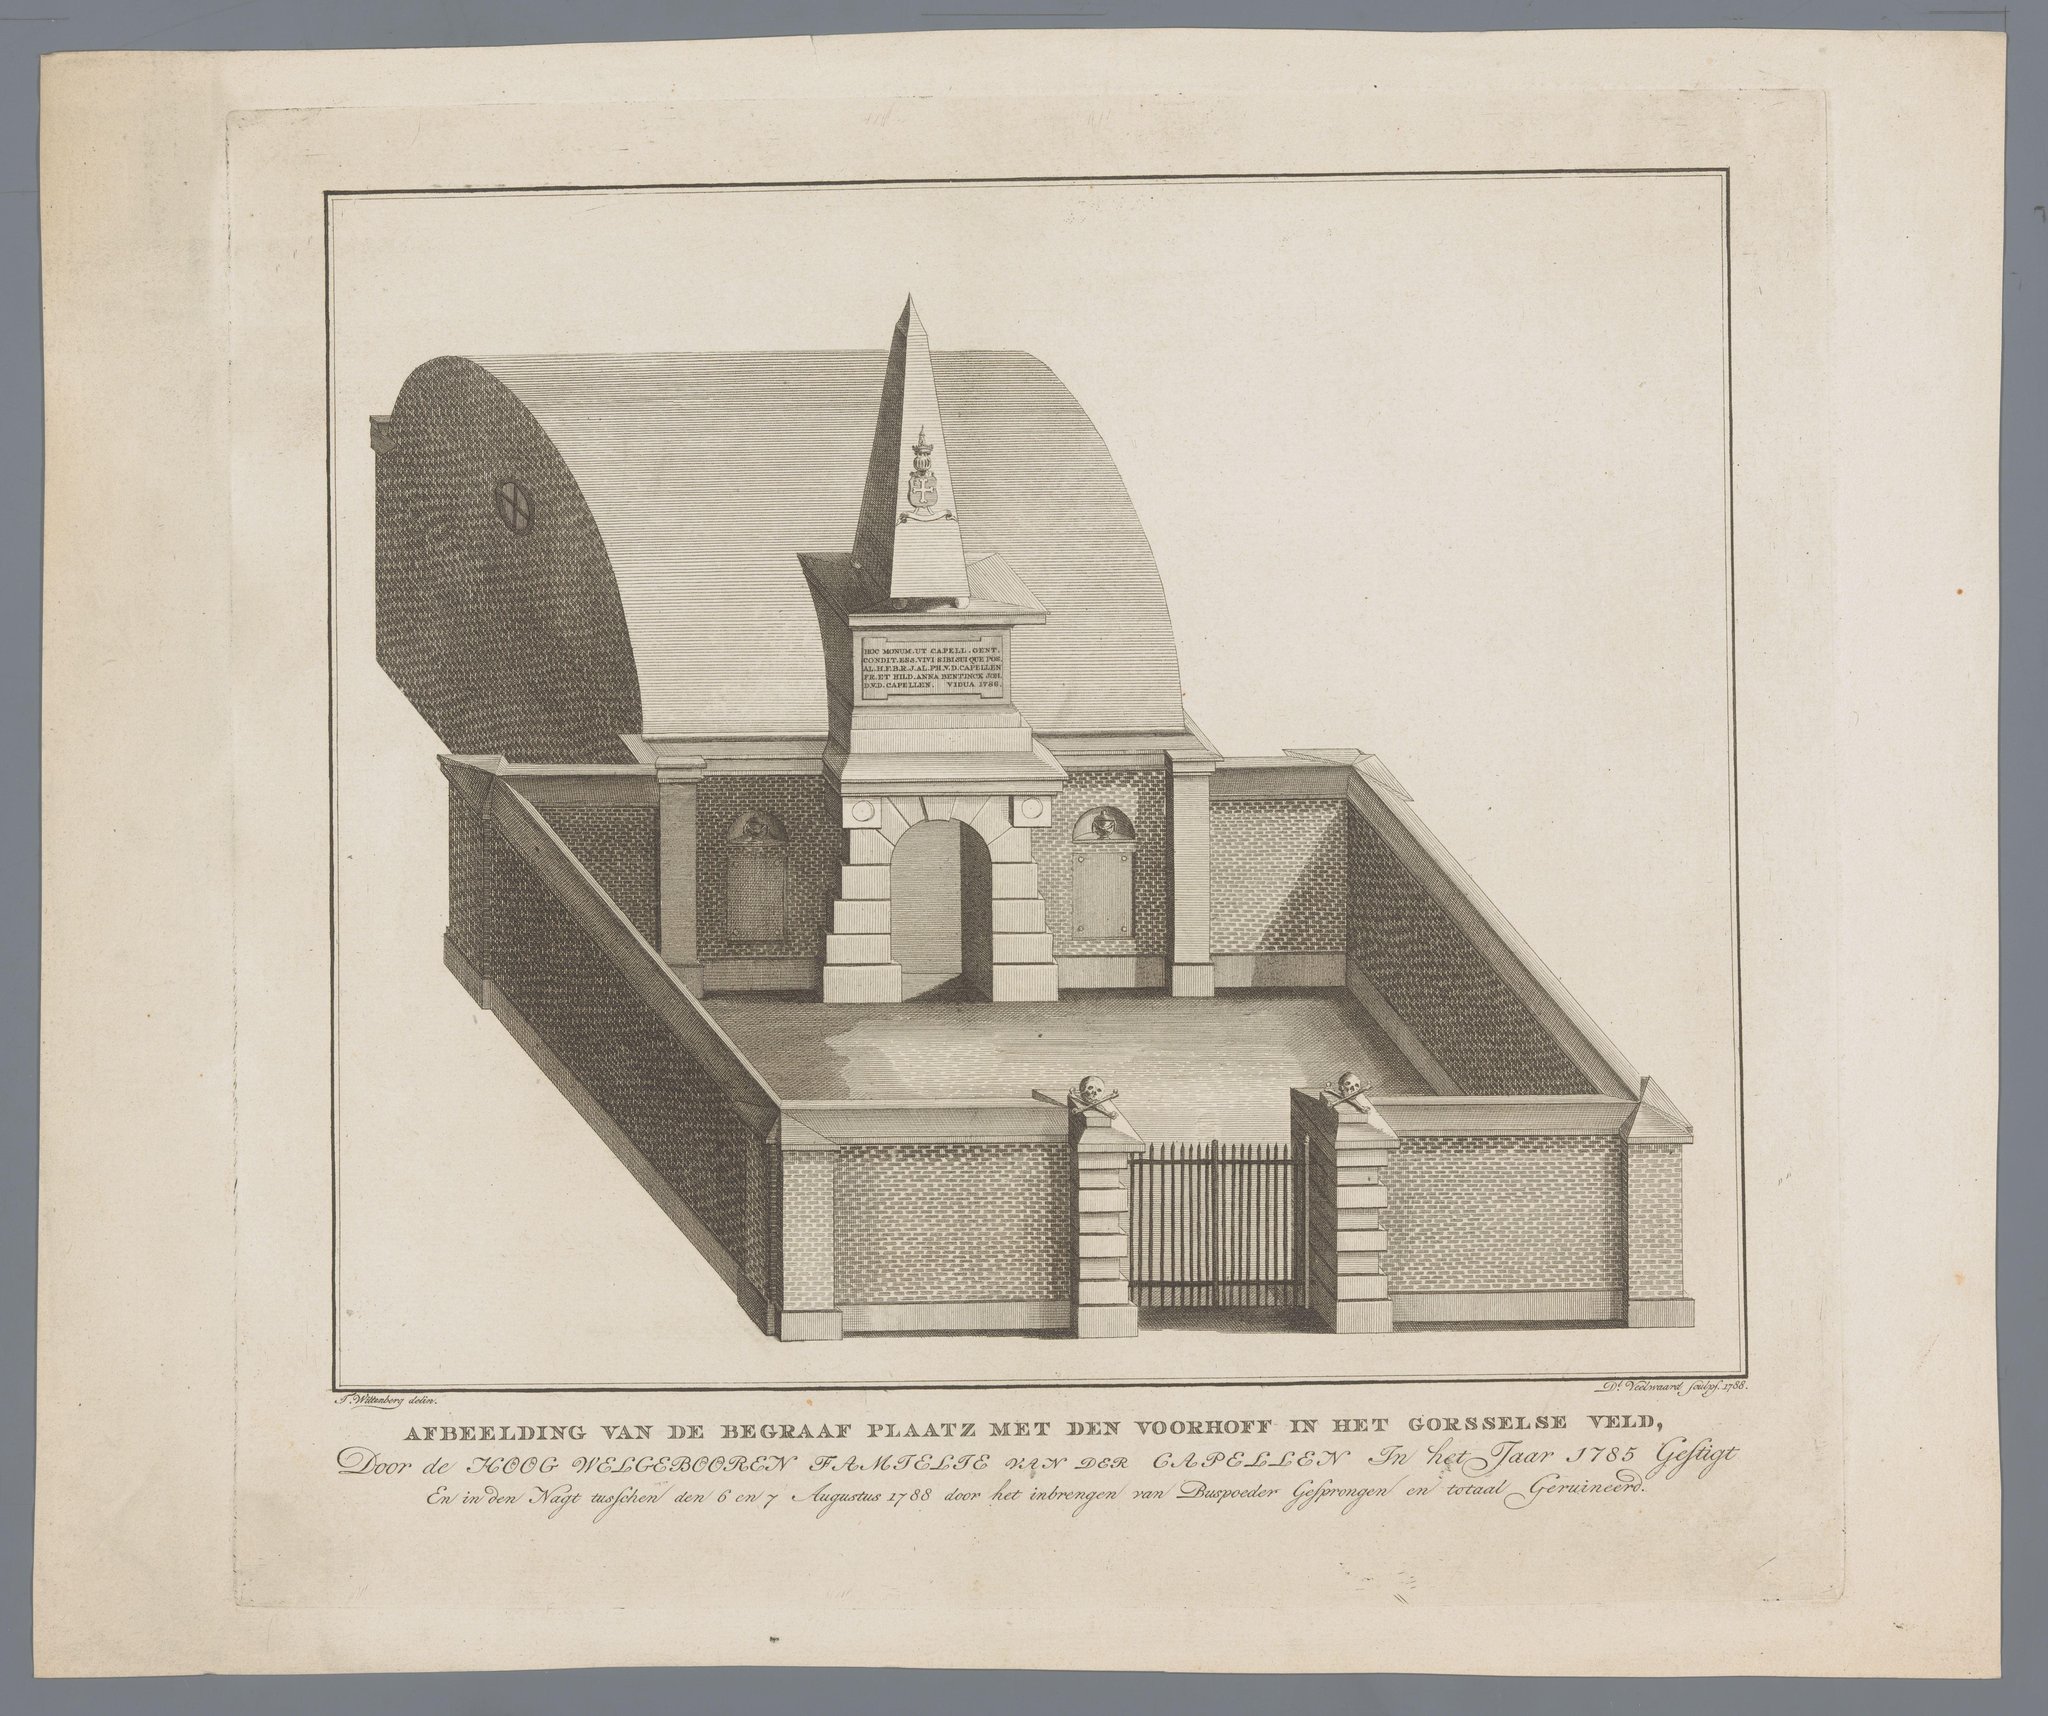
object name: print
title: Begraafplaats van de familie Van der Capellen in het Gorsselse Veld, 1785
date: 1788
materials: paper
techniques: etching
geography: amsterdam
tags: joan derk van der capellen tot den pol, grave-building, monumental tomb, patriots (1780-1795)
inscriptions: collector's mark: Lugt 2233